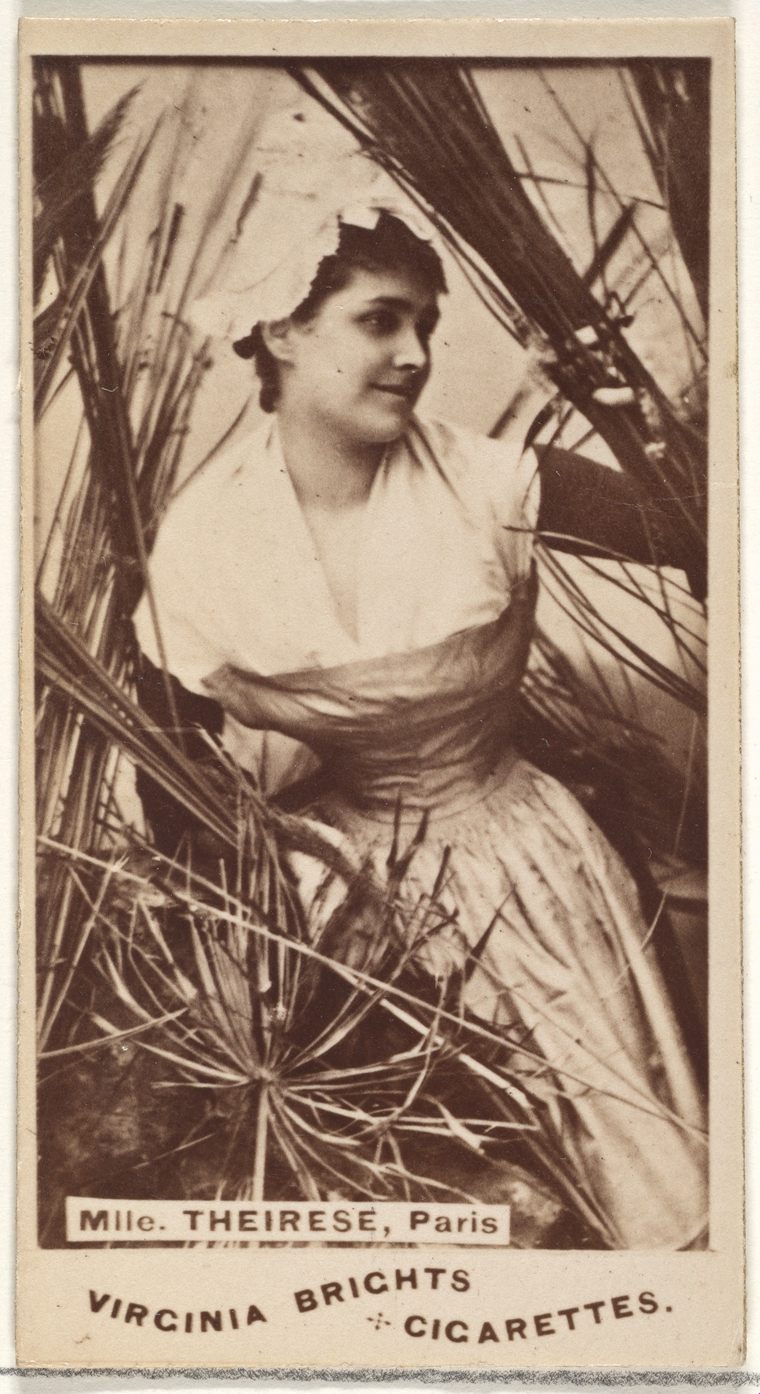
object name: photograph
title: Mlle. Theirese, Paris, from the Actors and Actresses series (N45, Type 1) for Virginia Brights Cigarettes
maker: allen & ginter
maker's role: publisher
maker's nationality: american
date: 1888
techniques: albumen silver print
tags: portraits,women,actresses